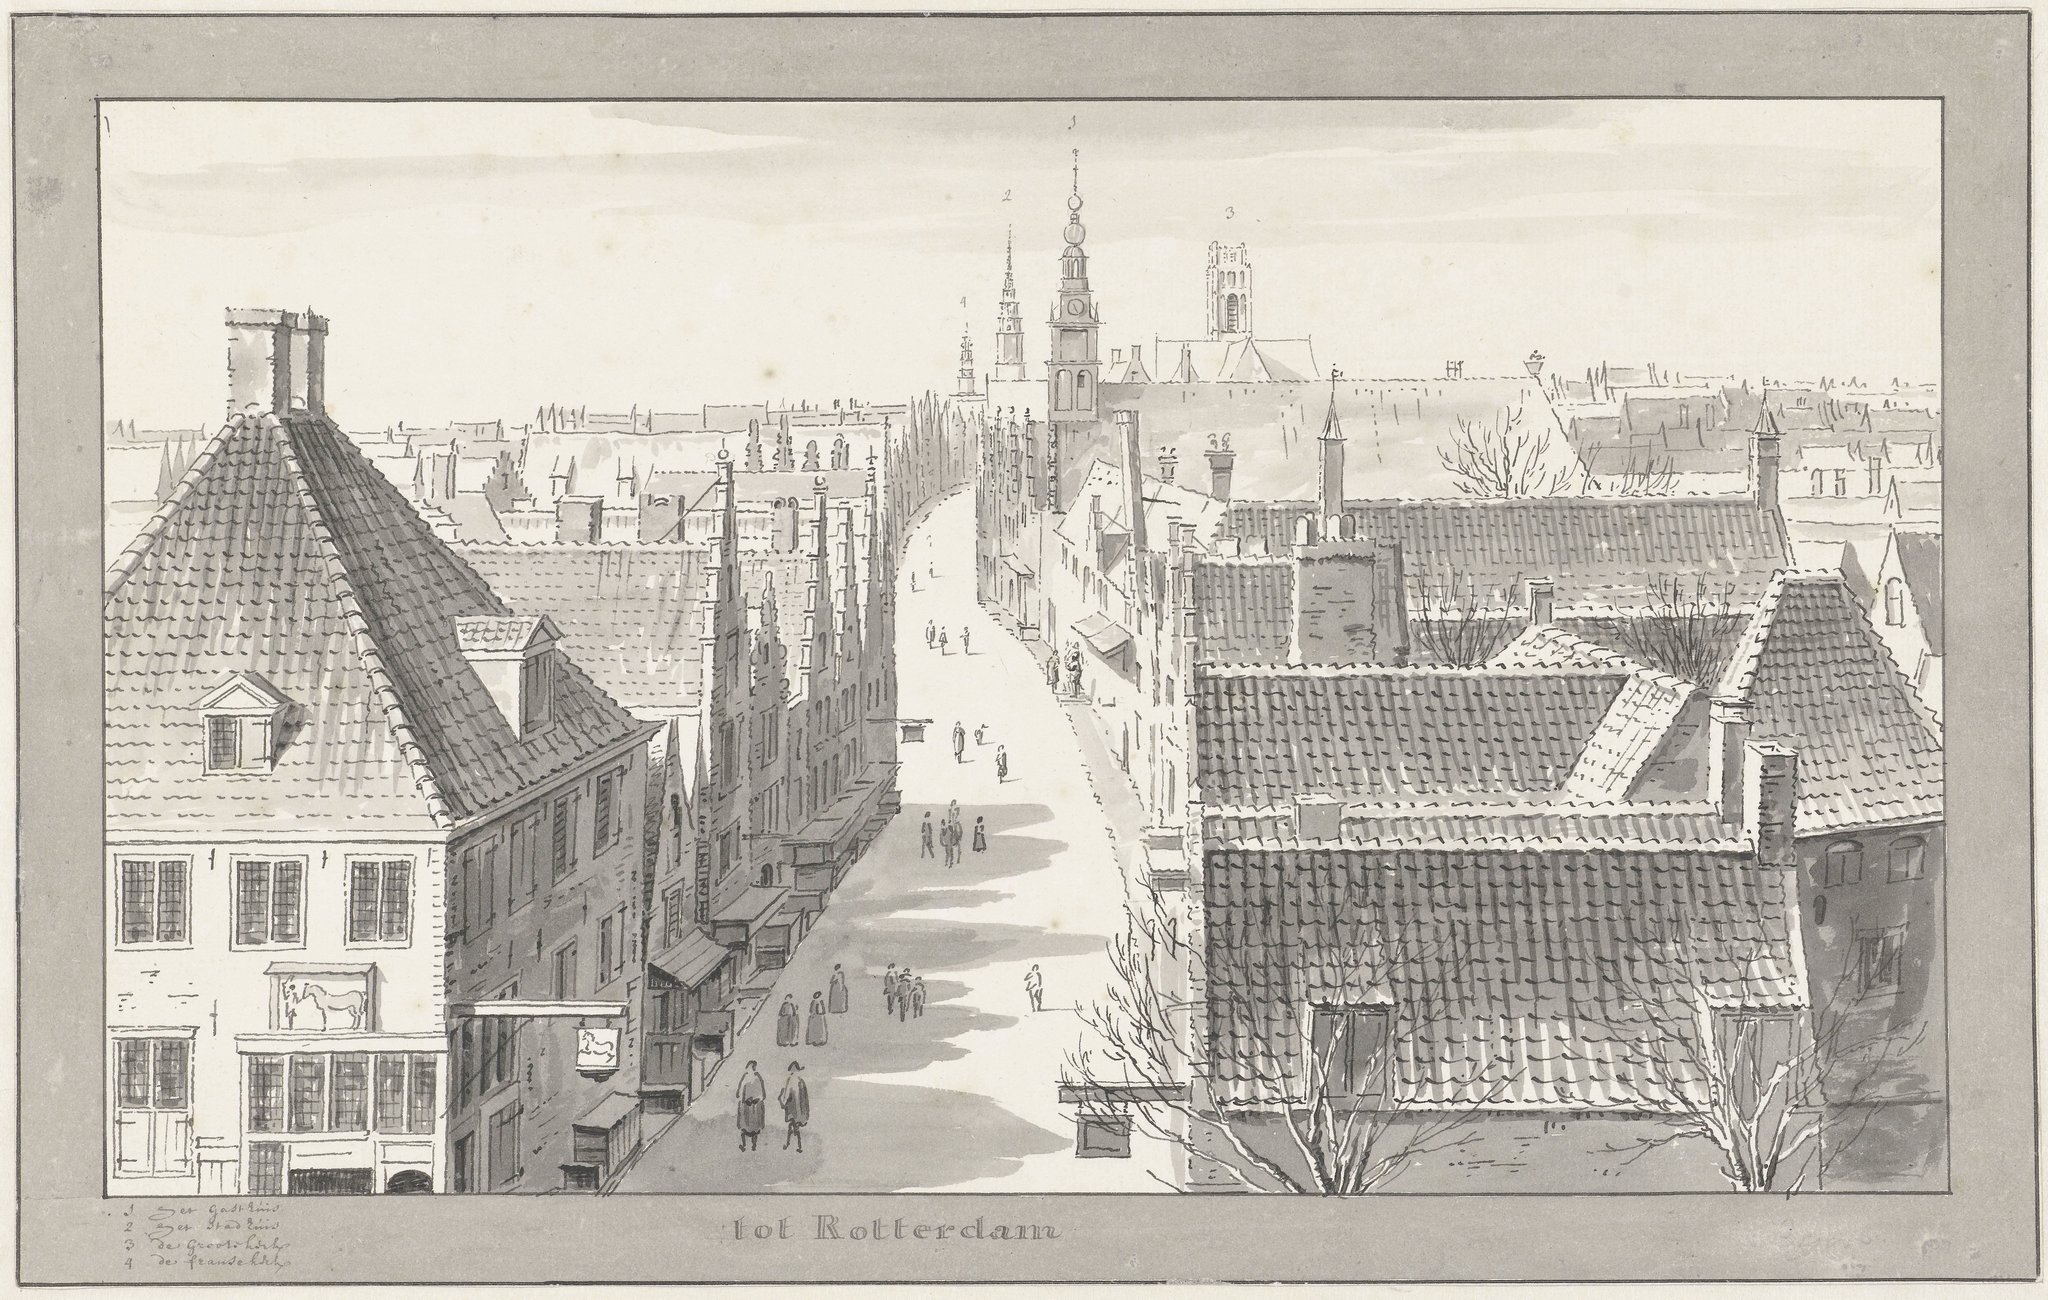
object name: drawing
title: De Hoogstraat te Rotterdam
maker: cornelis pronk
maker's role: draughtsman, painter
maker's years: 1691-1759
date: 1701-1759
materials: ink, paper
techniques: brush, pen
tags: street, prospect of city, town panorama, silhouette of city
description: De Hoogstraat te Rotterdam, gezien vanaf de Oostpoort naar het westen. Onder: 1. het gasthuis / 2. het Stadhuis / 3. de Groote kerk / 4. de franse kerk / tot Rotterdam.